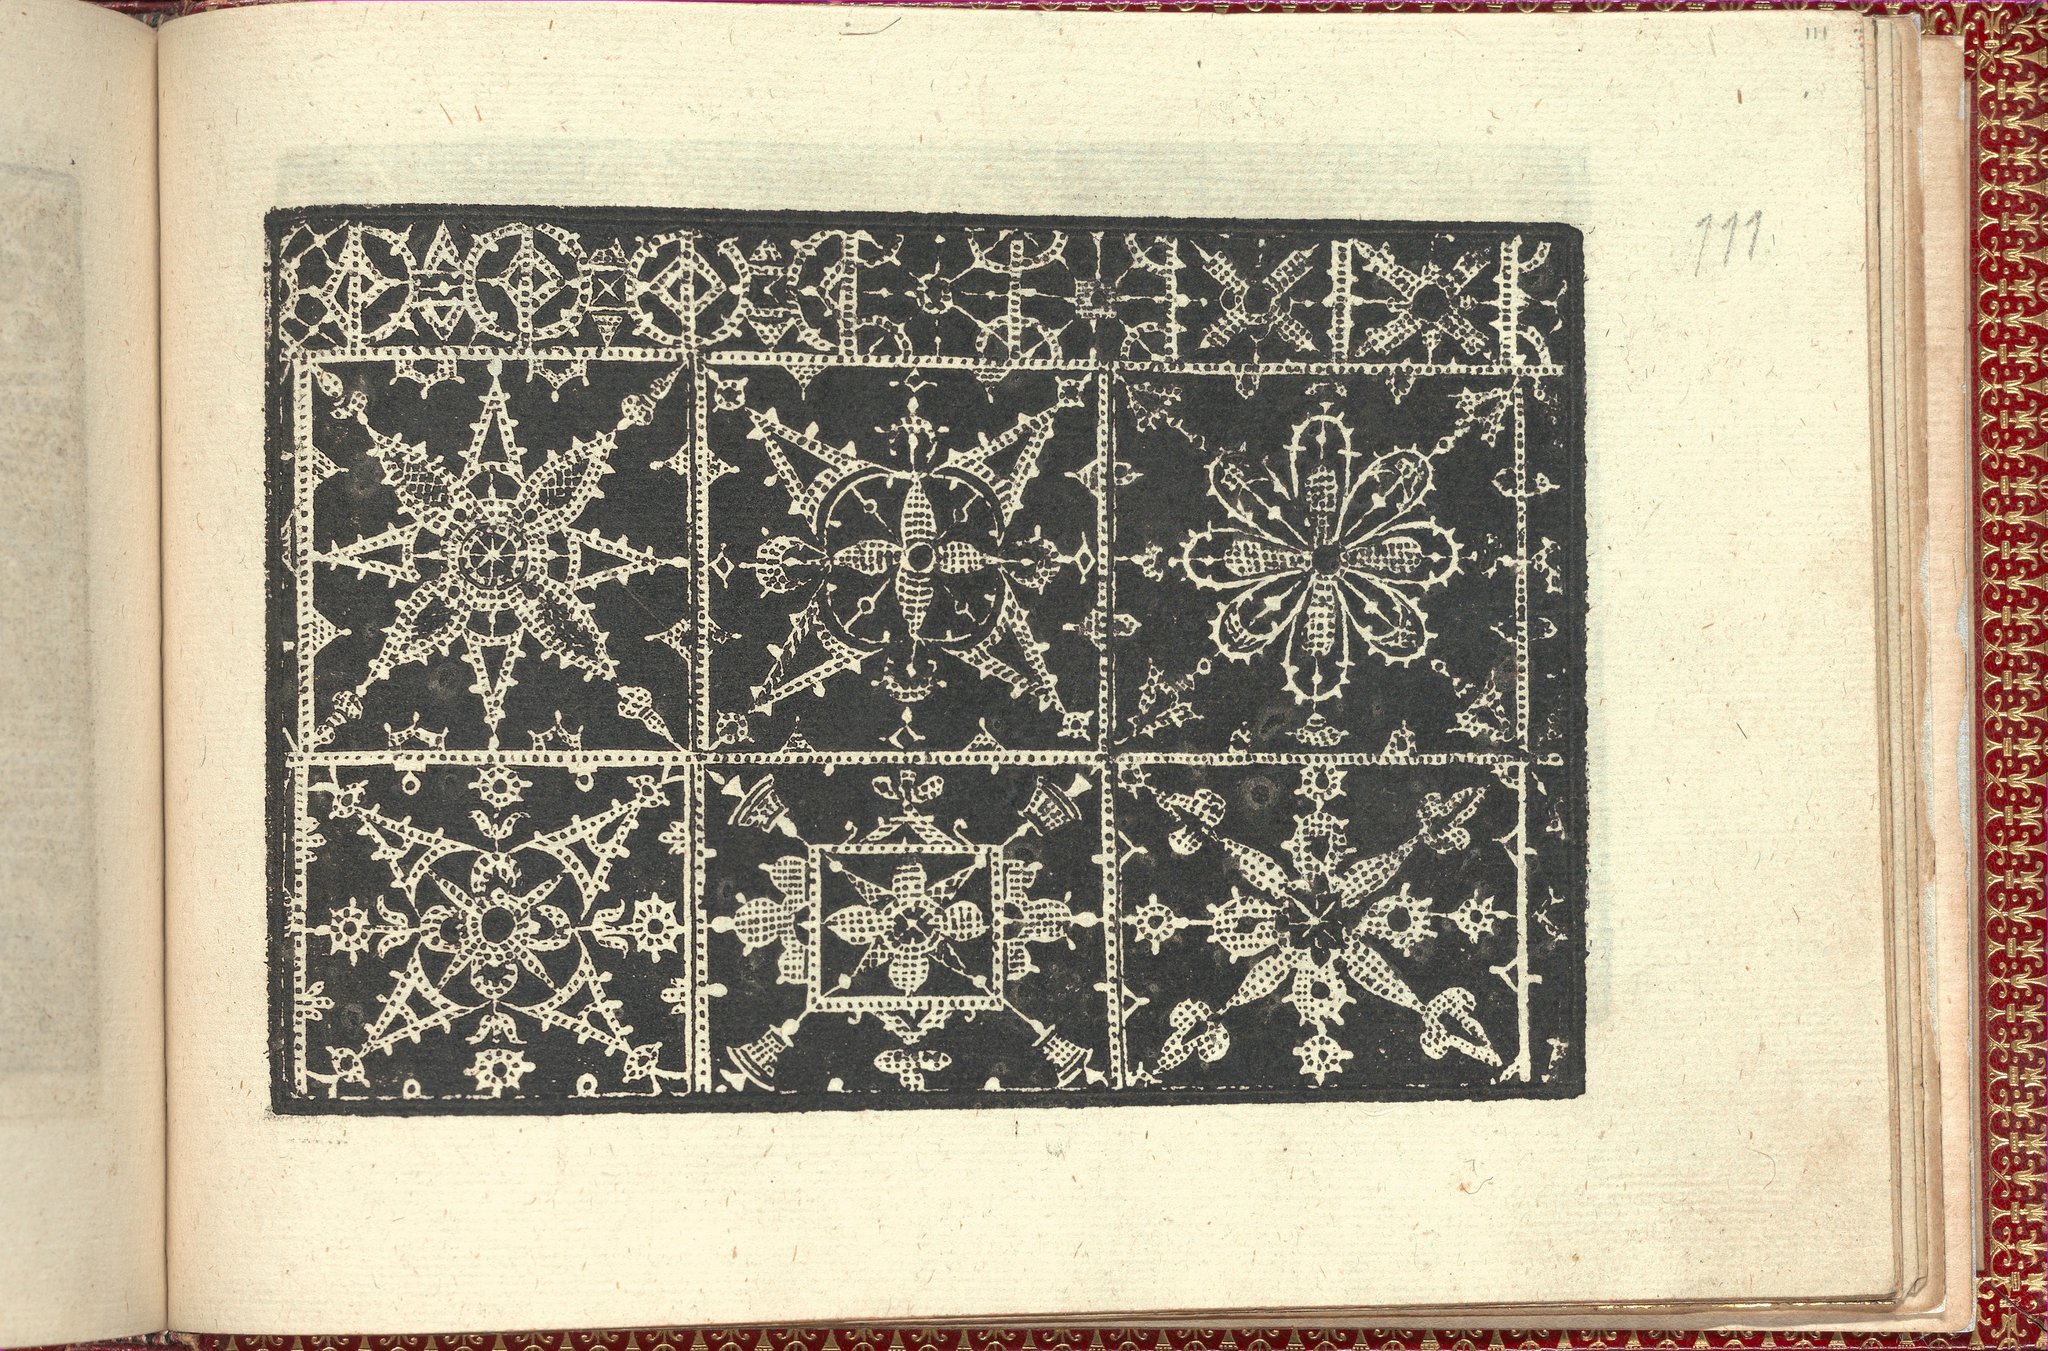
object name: book print ornament architecture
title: Corona delle Nobili et Virtuose Donne: Libro I-IV, page 111 (recto)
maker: cesare vecellio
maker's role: publisher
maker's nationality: italian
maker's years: 1521-1601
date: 1601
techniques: woodcut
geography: italy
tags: ornament